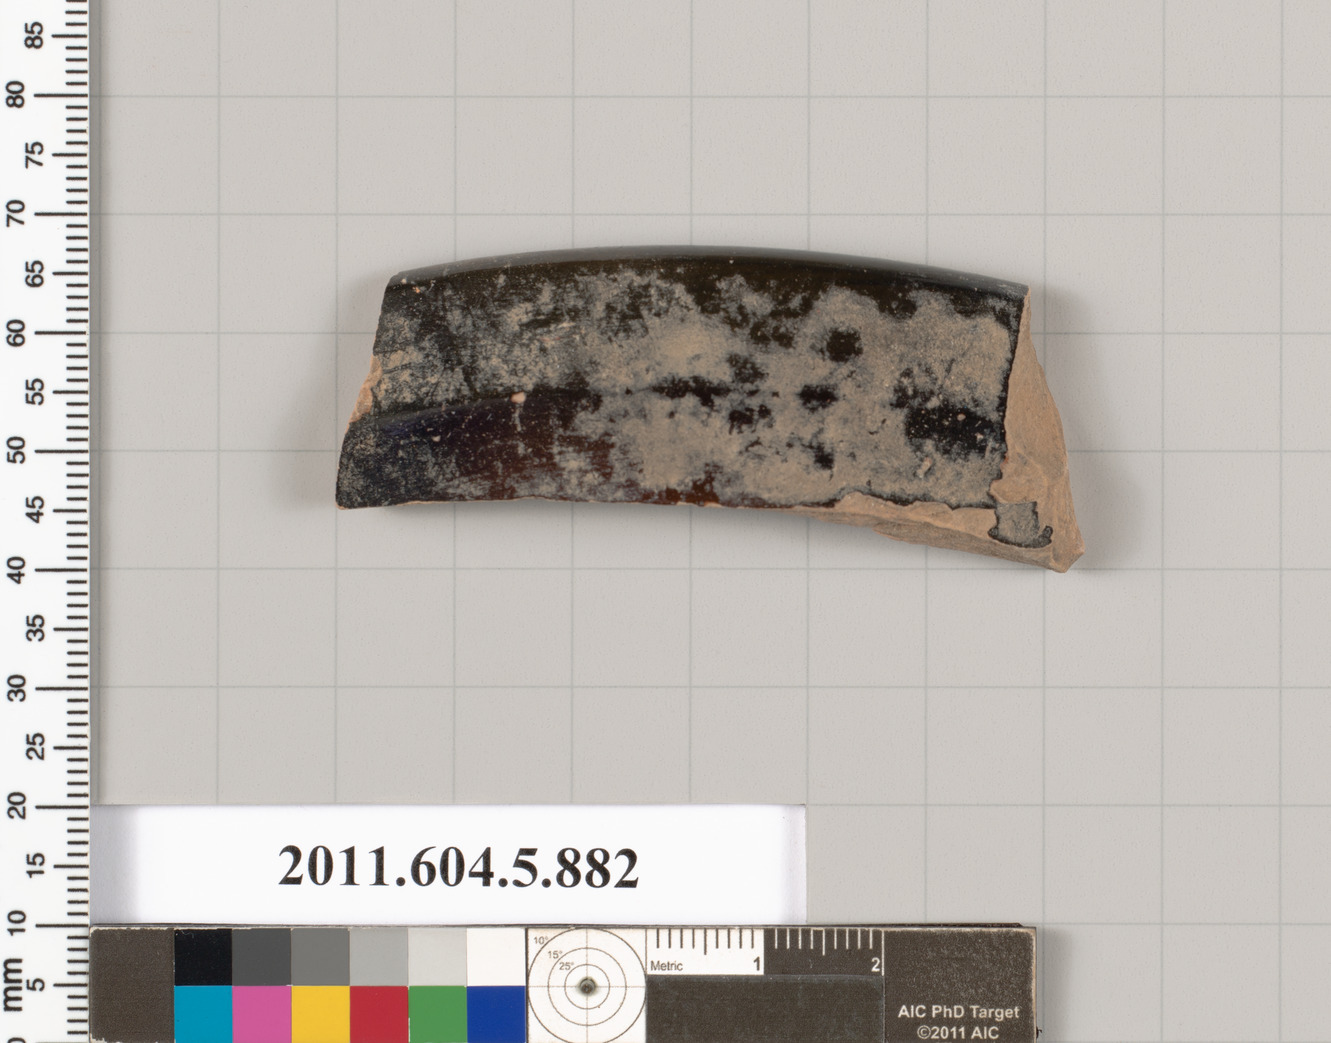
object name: kylix fragment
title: Terracotta rim fragment of a kylix (drinking cup)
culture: greek, attic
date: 600-401 BCE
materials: terracotta